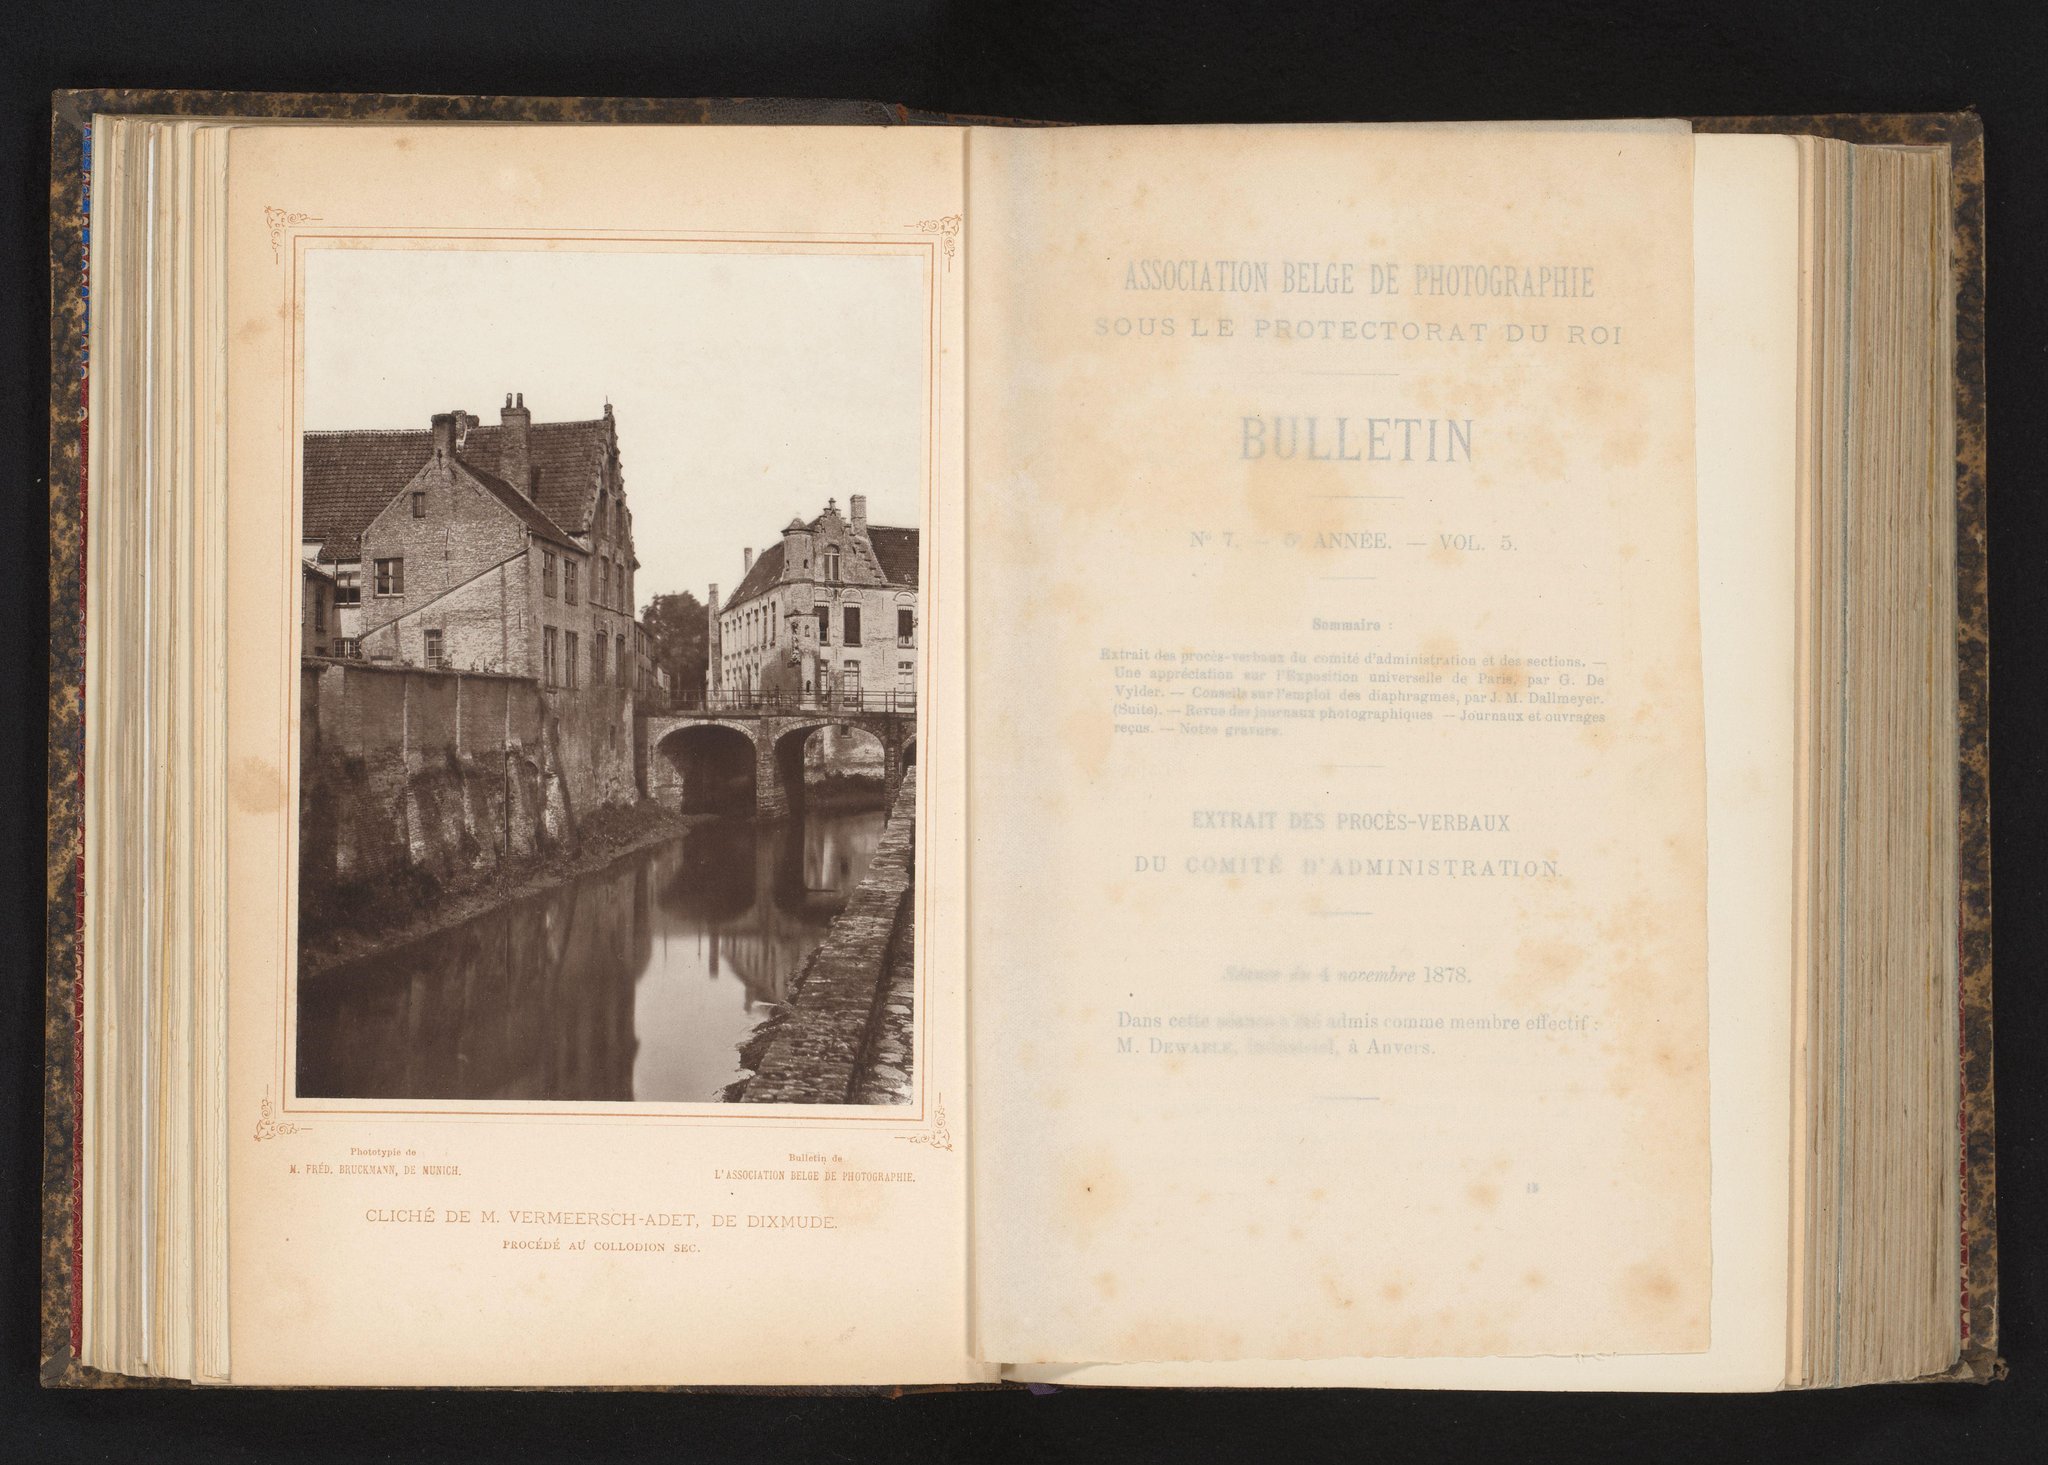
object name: photomechanical print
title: Gezicht op een gracht in Diksmuide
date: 1873-1878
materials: paper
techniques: photograph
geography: munich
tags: canals, waters (in city), civic architecture; edifices; dwellings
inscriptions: inscription: ‘Bulletin de l'Association Belge de Photographie’